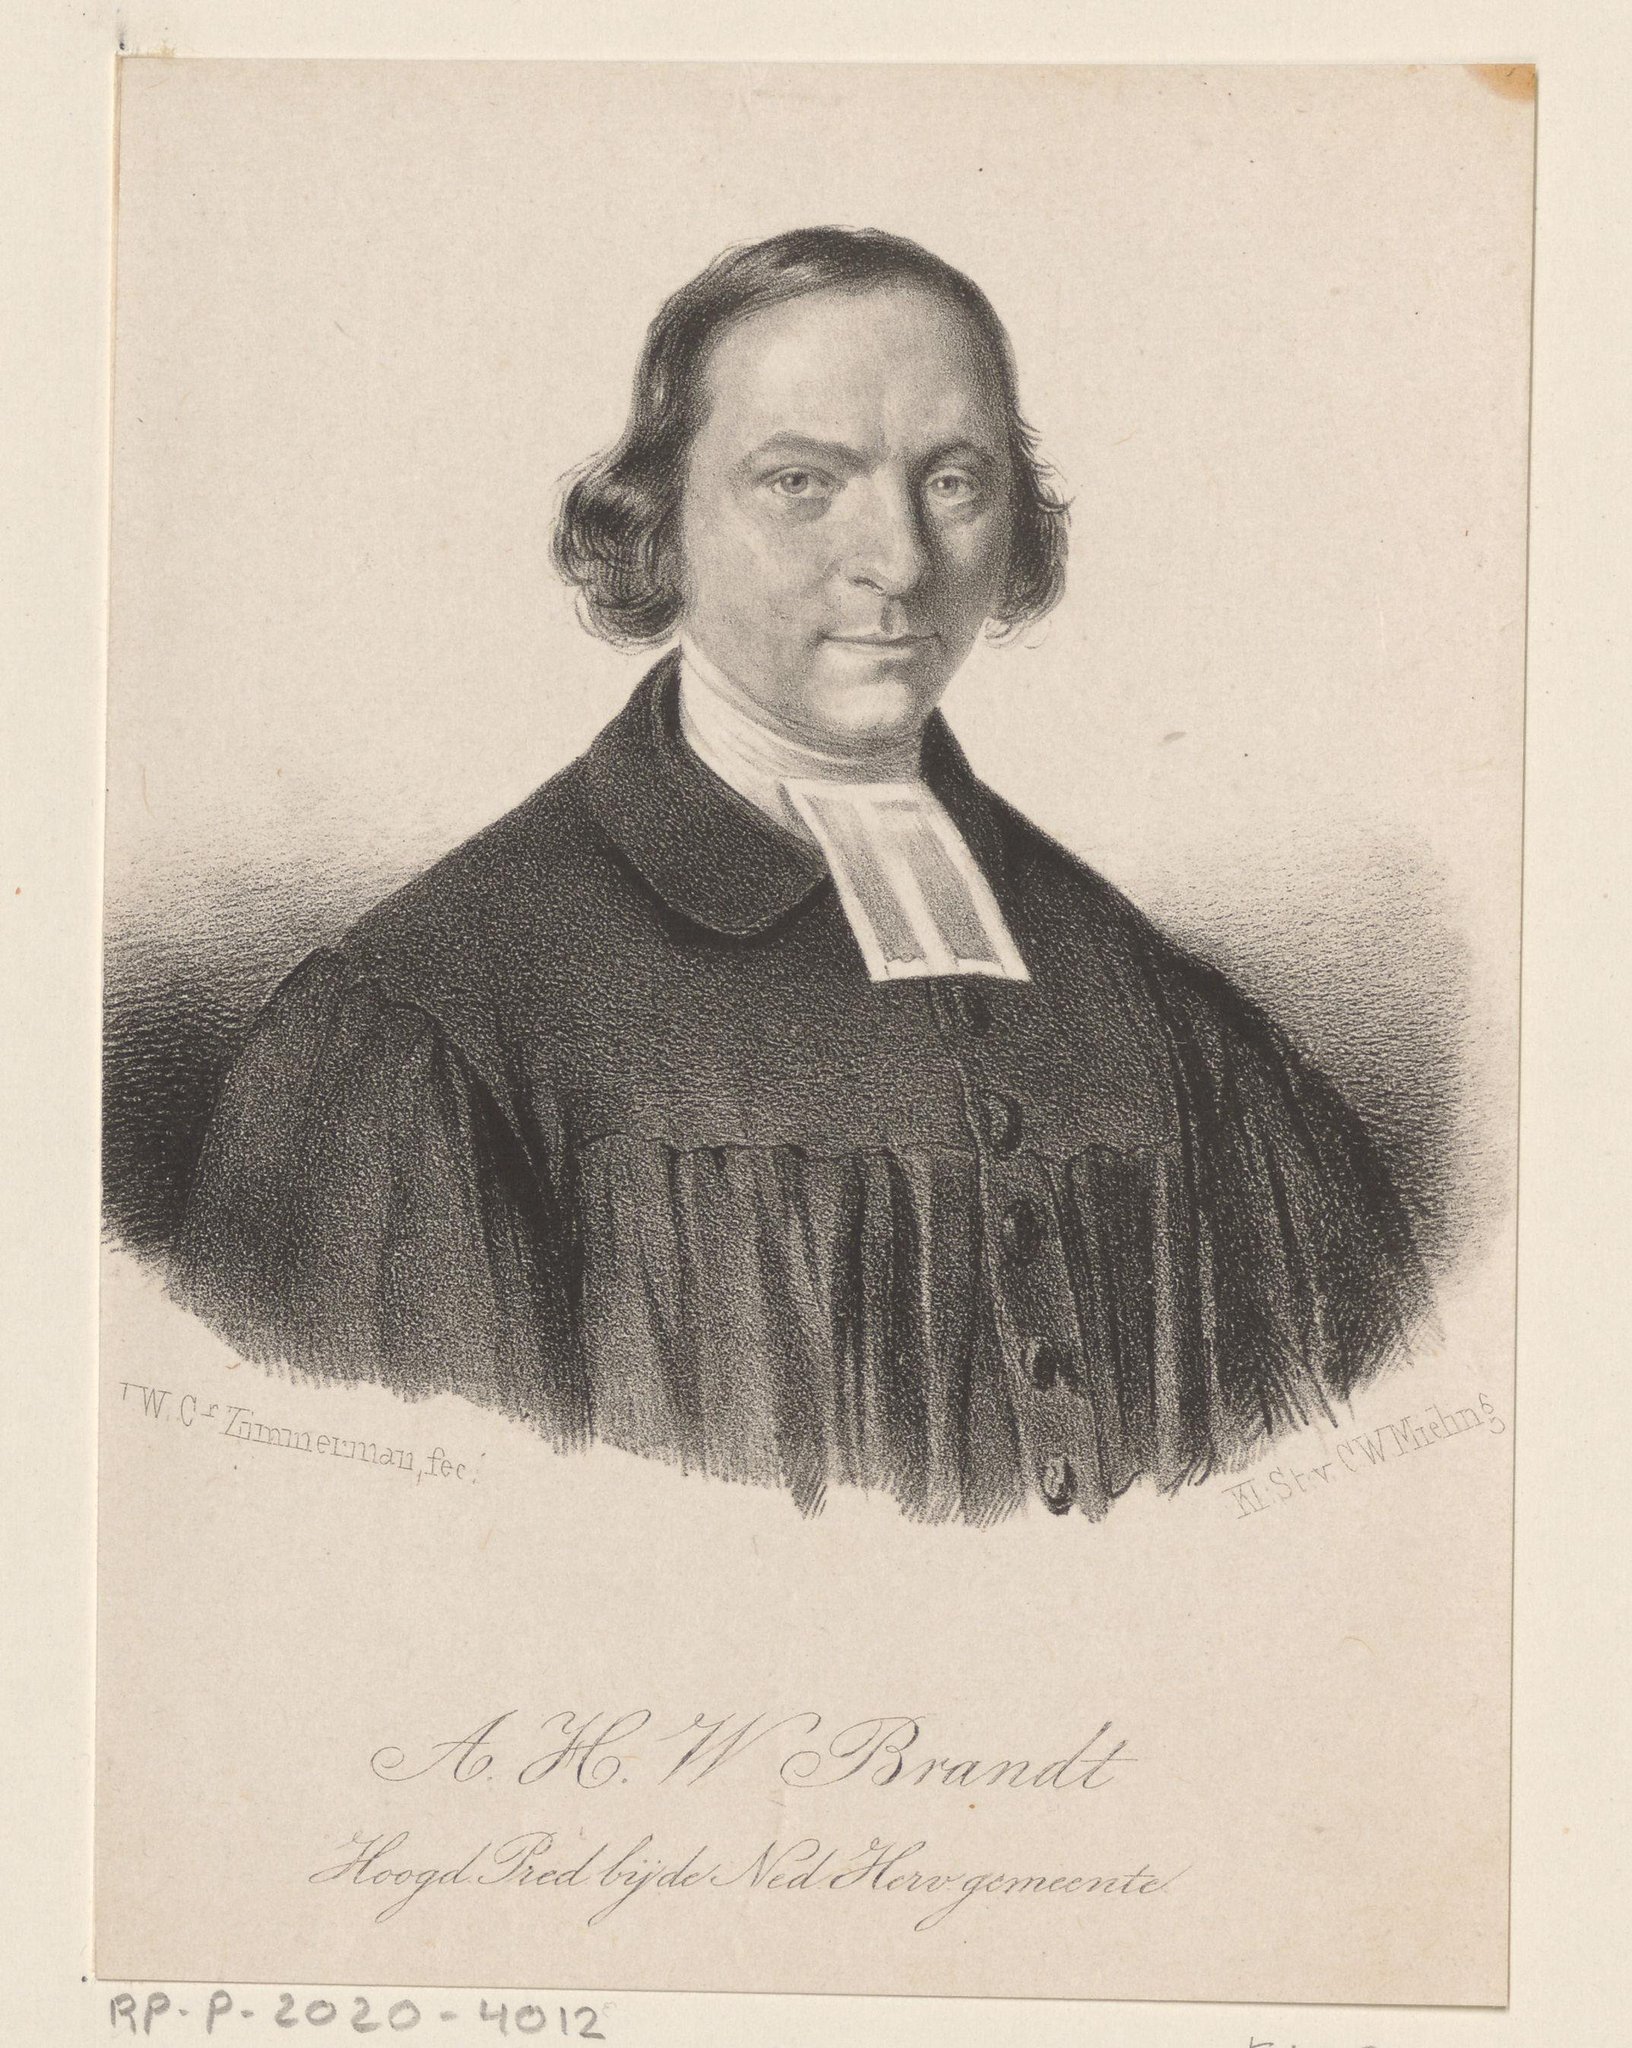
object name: print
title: Portret van A.H.W. Brandt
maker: jan wendel gerstenhauer zimmerman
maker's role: draughtsman, print maker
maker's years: 1816-1887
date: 1839-1847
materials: paper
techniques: lithograph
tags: historical persons